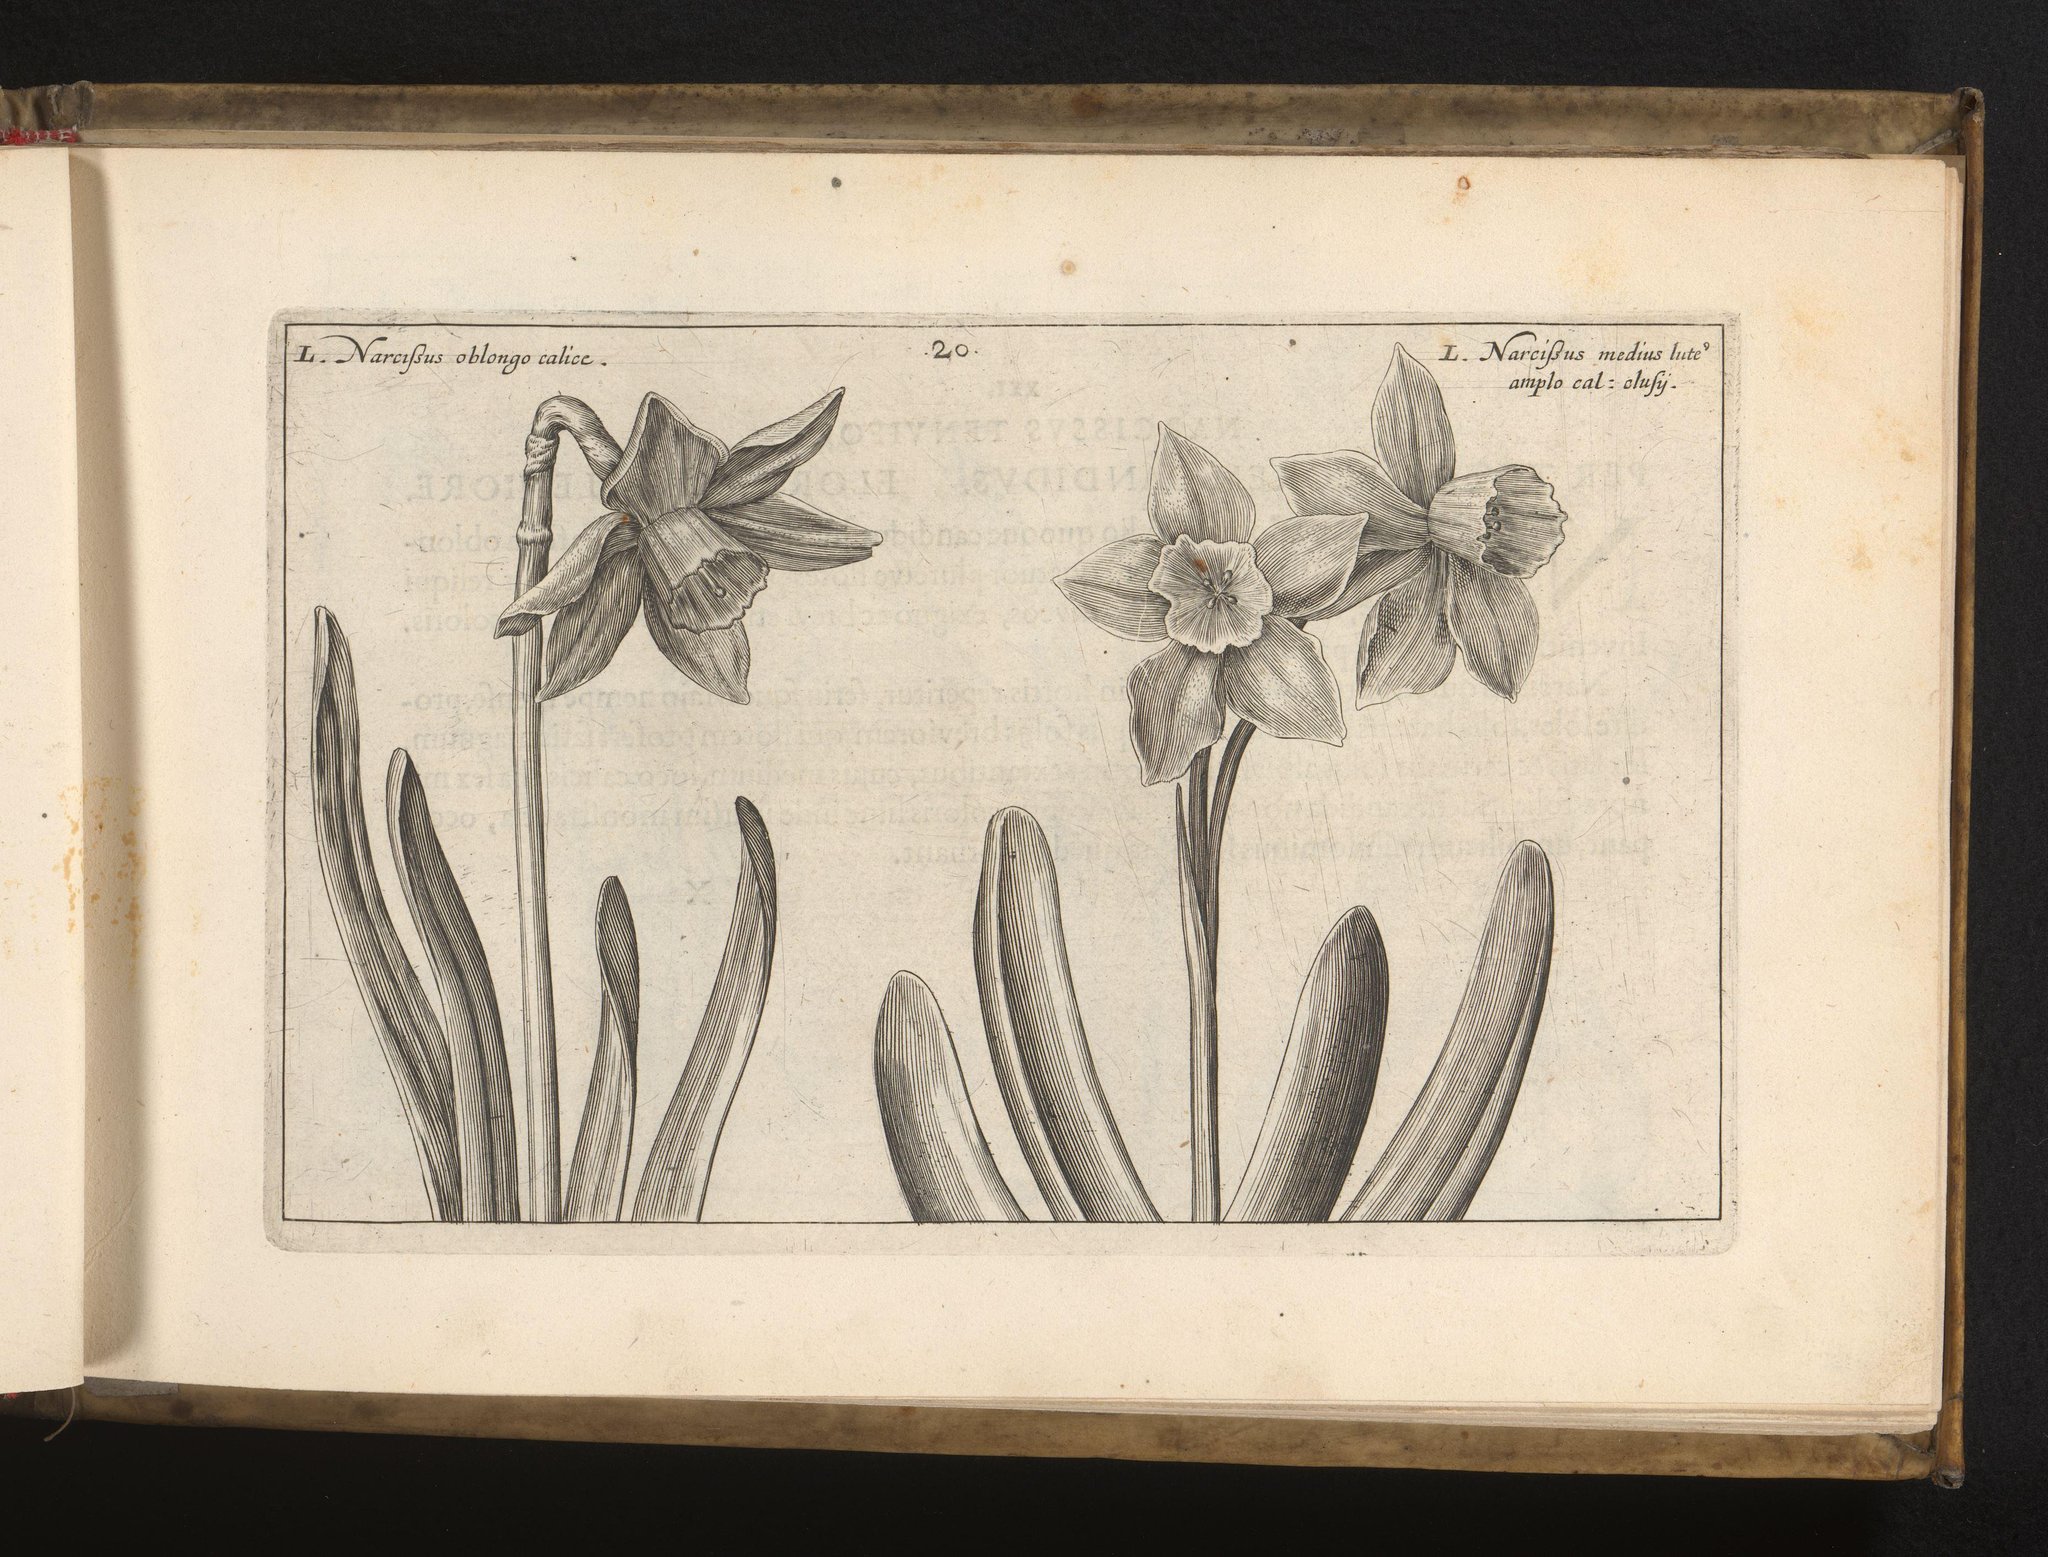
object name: page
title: Bloementuin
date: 1617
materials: paper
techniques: engraving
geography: arnhem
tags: flowers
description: Prent uit: Passe, Crispijn van de (II). Hortus floridus in quo rariorum & minus vulgarium florum icones ad vivam veramque formam. Arnhem: Johannes Janssonius, 1617.